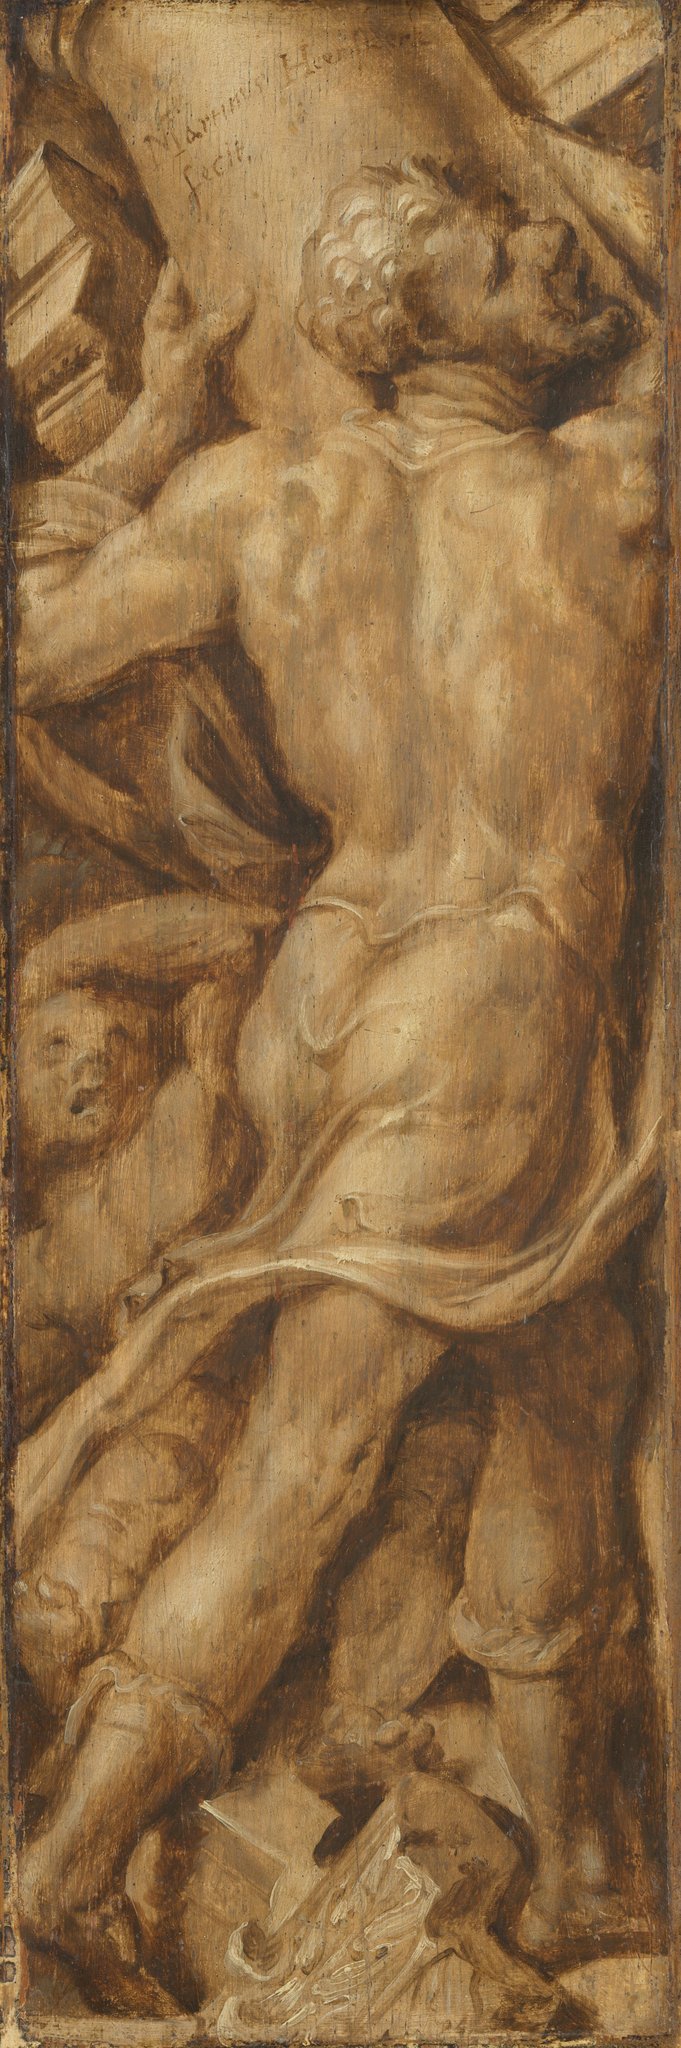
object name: grisaille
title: Samson Shattering the Pillars of the Temple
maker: martinus van heemskerck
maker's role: draughtsman, painter, print maker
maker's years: 1498-1574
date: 1550-1560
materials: oil, panel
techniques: grisaille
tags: samson breaks the pillars; the temple of dagon collapses, killing all that are in it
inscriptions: signature, top, on the column: ‘Martinus Heemskerck fecit’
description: Like Christ many centuries later, Samson died as a saviour to redeem the sins of the people of Israel. As a punishment for their sins, God had placed the Israelites under the yoke of the Philistines. Blinded and imprisoned by the Philistines, Samson destroyed the temple, killing himself and countless Philistines. According to the Bible story, Samson tore down two pillars. Because of the panel’s narrow dimensions, Heemskerck portrayed Samson with his arms wrapped around only one pillar.